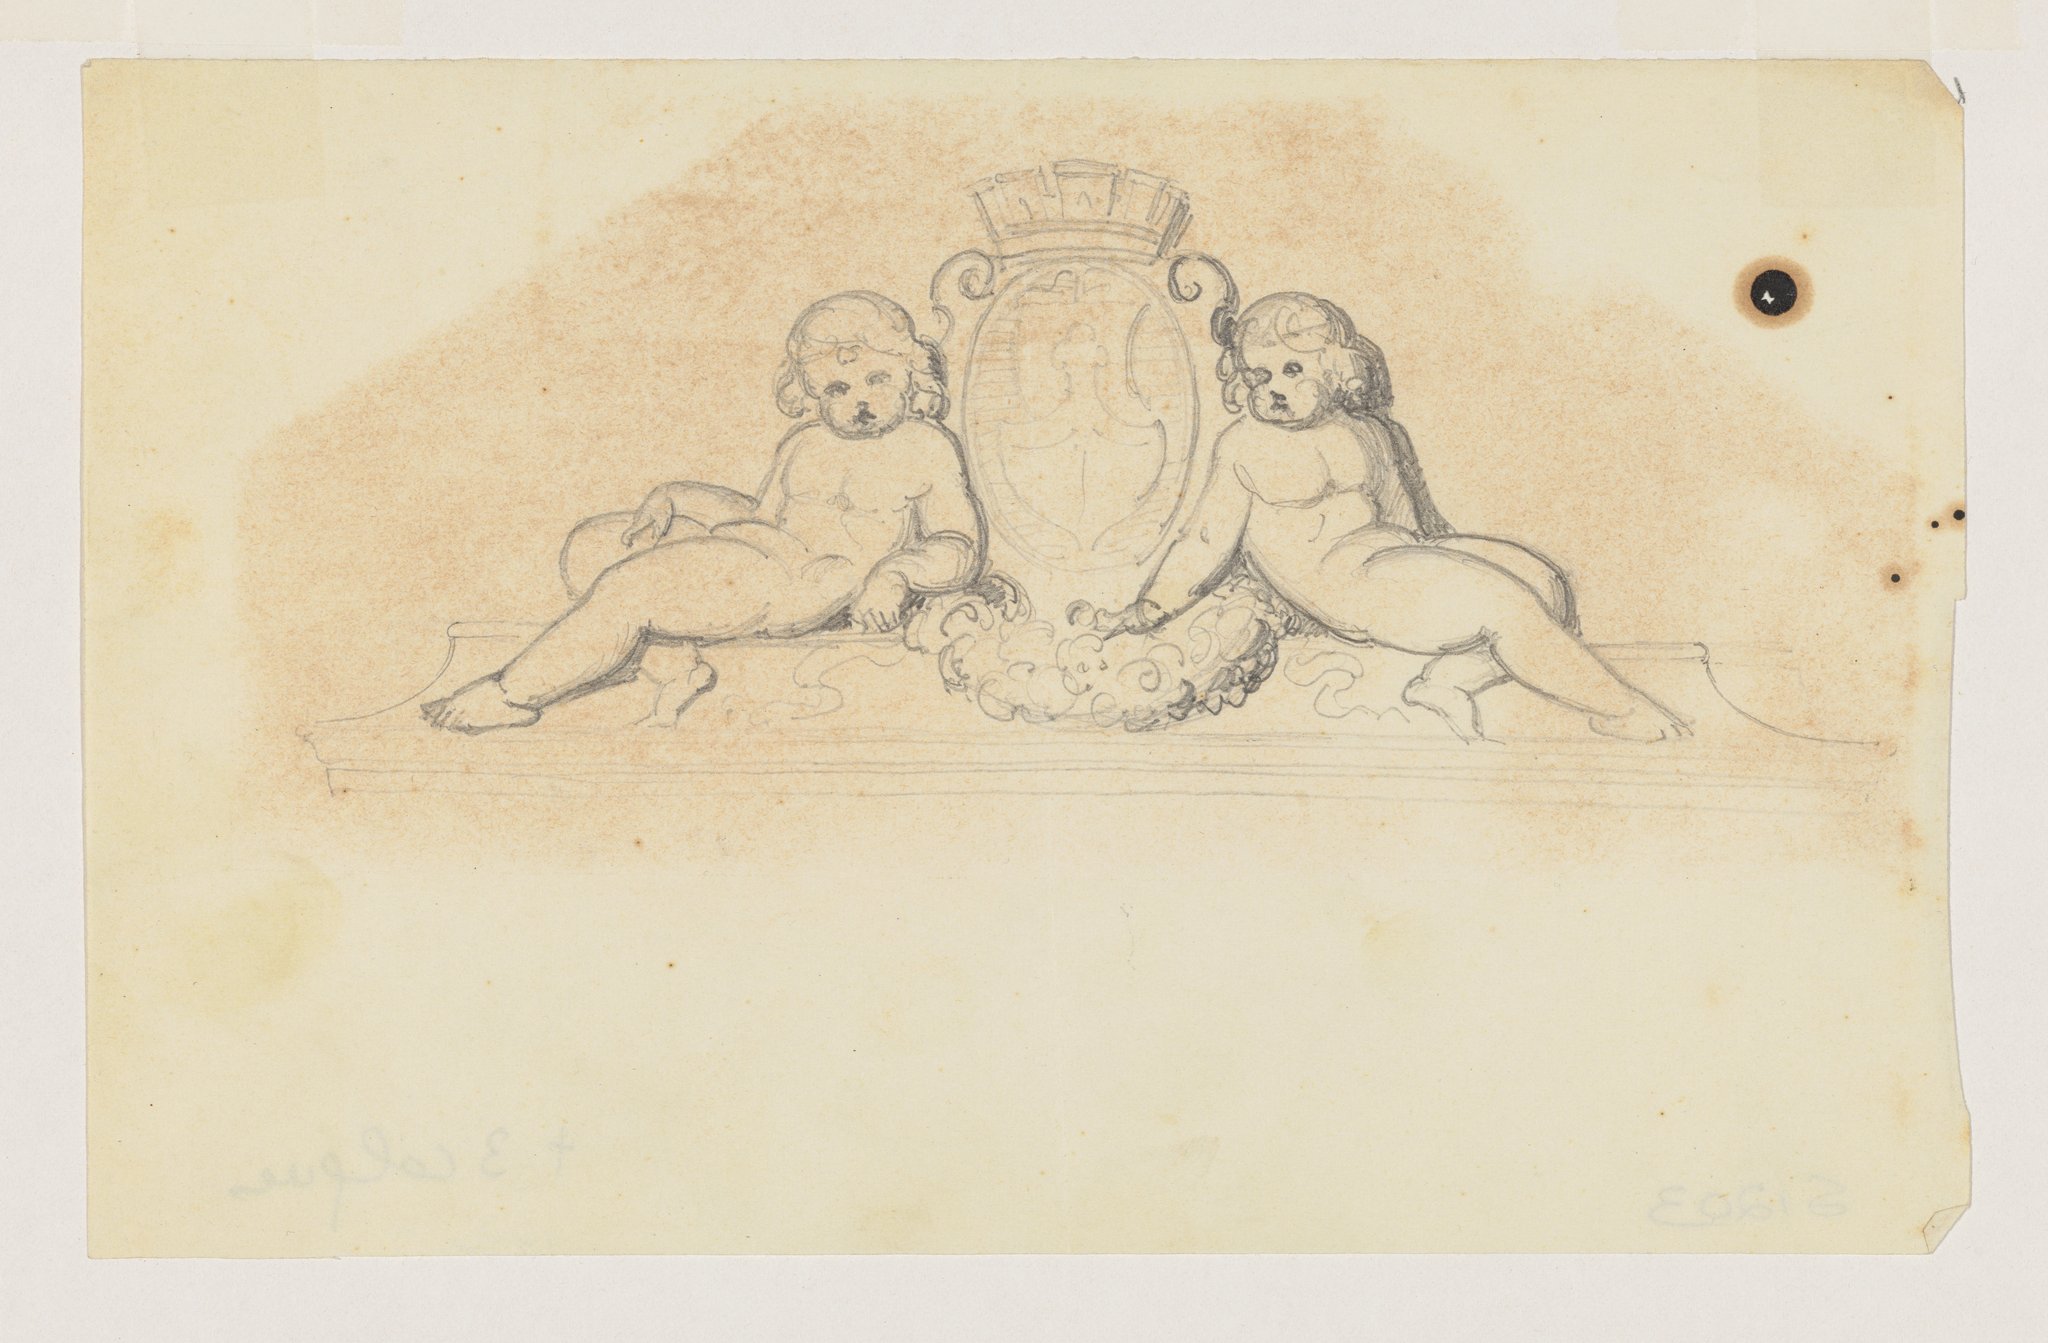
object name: drawing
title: Design for an Overdoor with Two Putti flanking a Coat of Arms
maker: jean-baptiste louis plantar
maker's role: artist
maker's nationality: french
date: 1834-1866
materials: graphite, ink, watercolor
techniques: pen